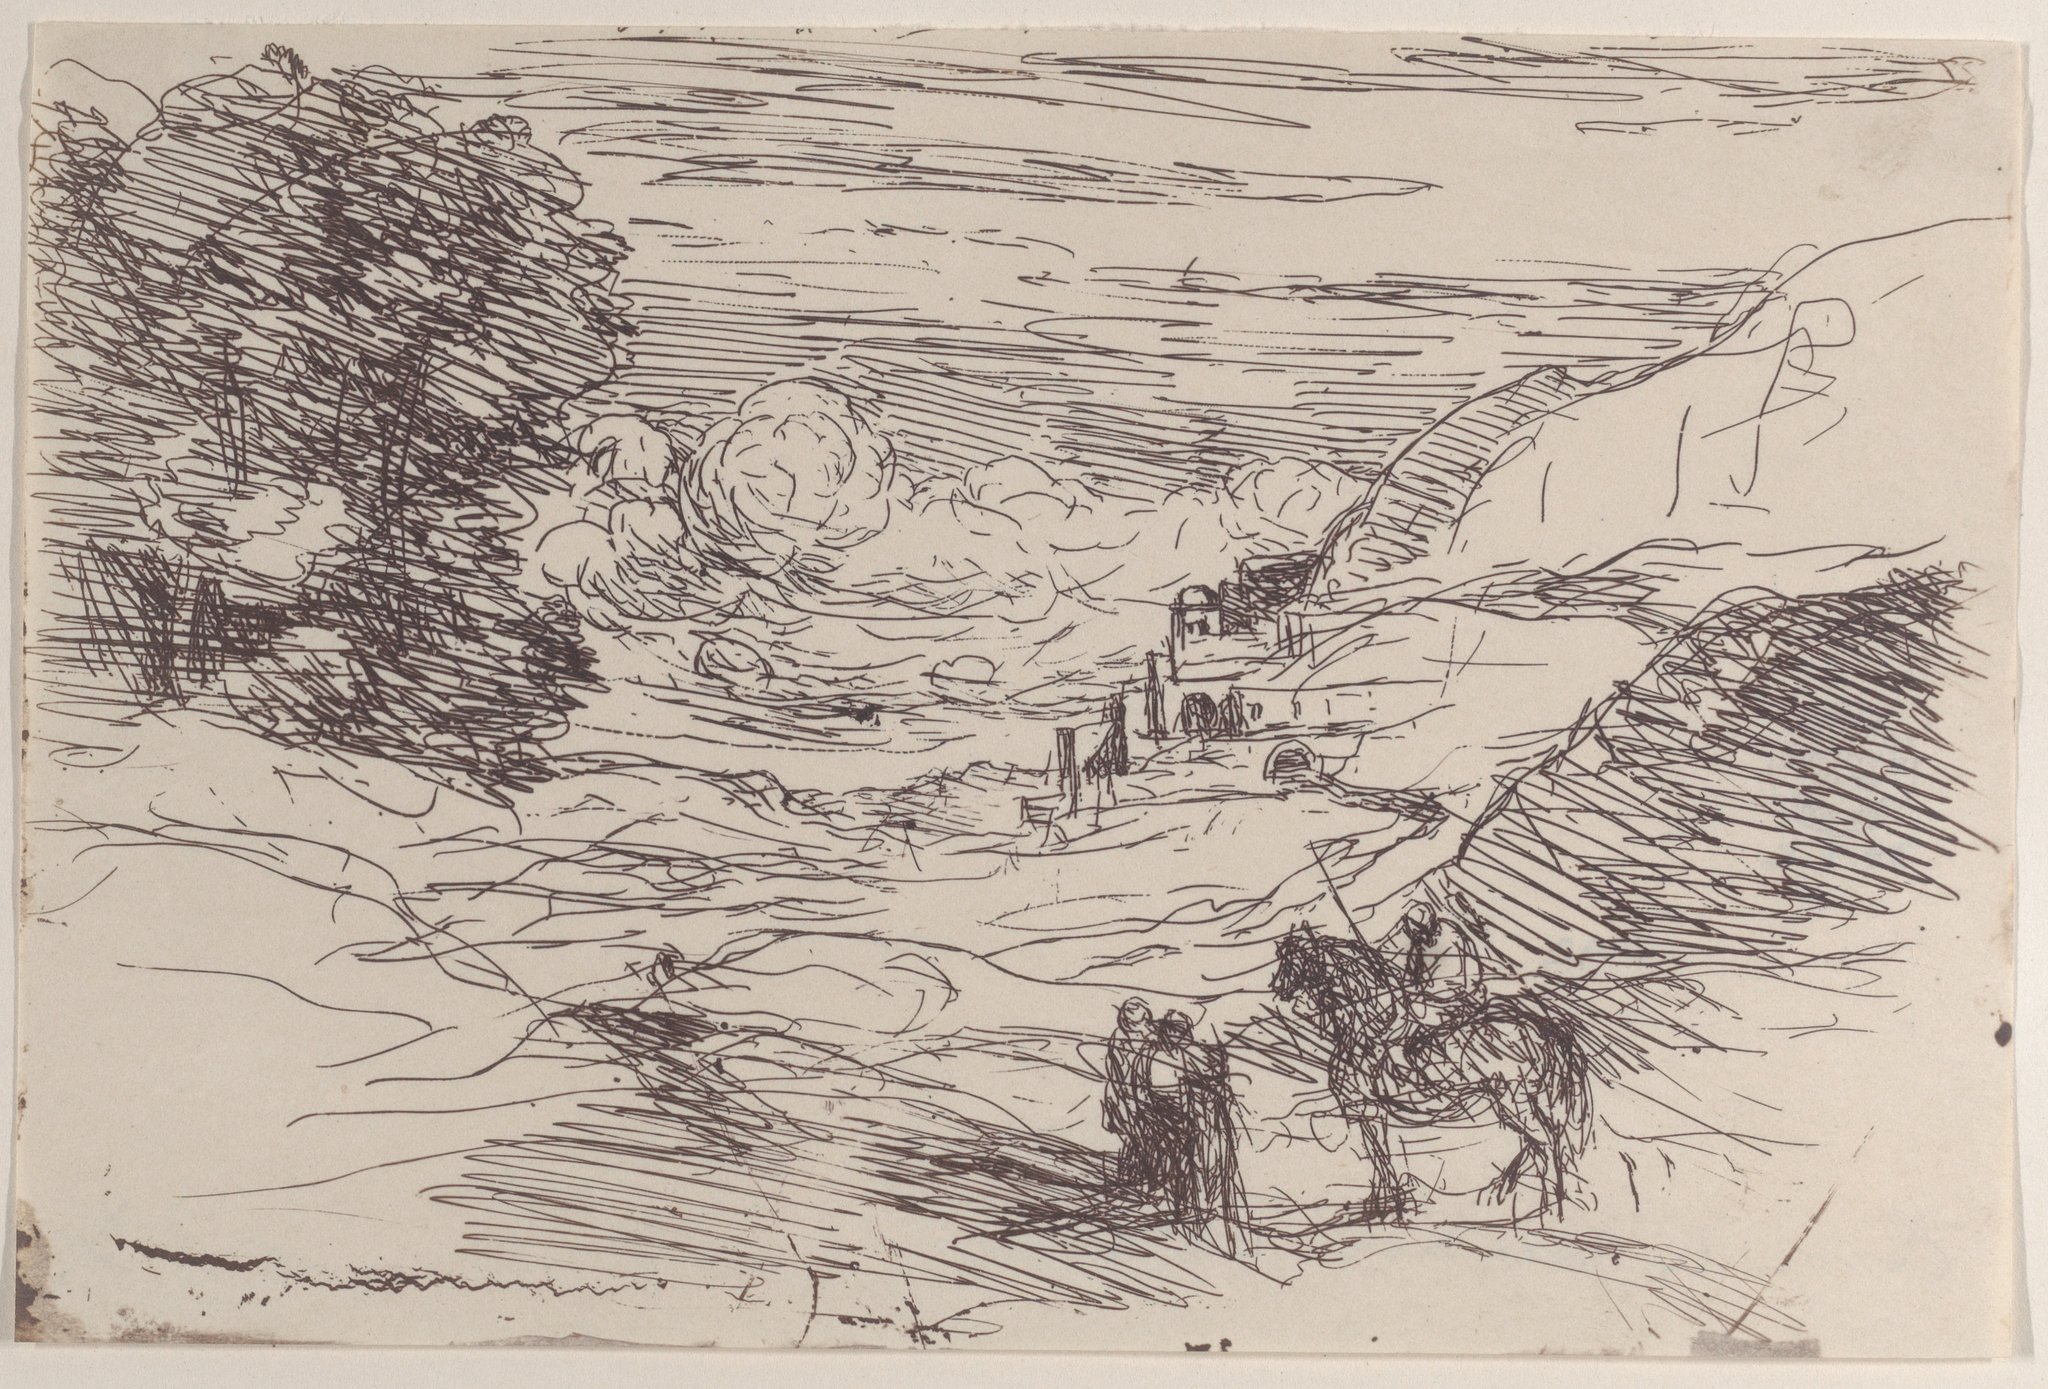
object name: print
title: Les Paladins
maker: jean-baptiste-camille corot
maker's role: artist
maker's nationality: french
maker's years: 1796-1875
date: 1871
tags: horses,landscapes